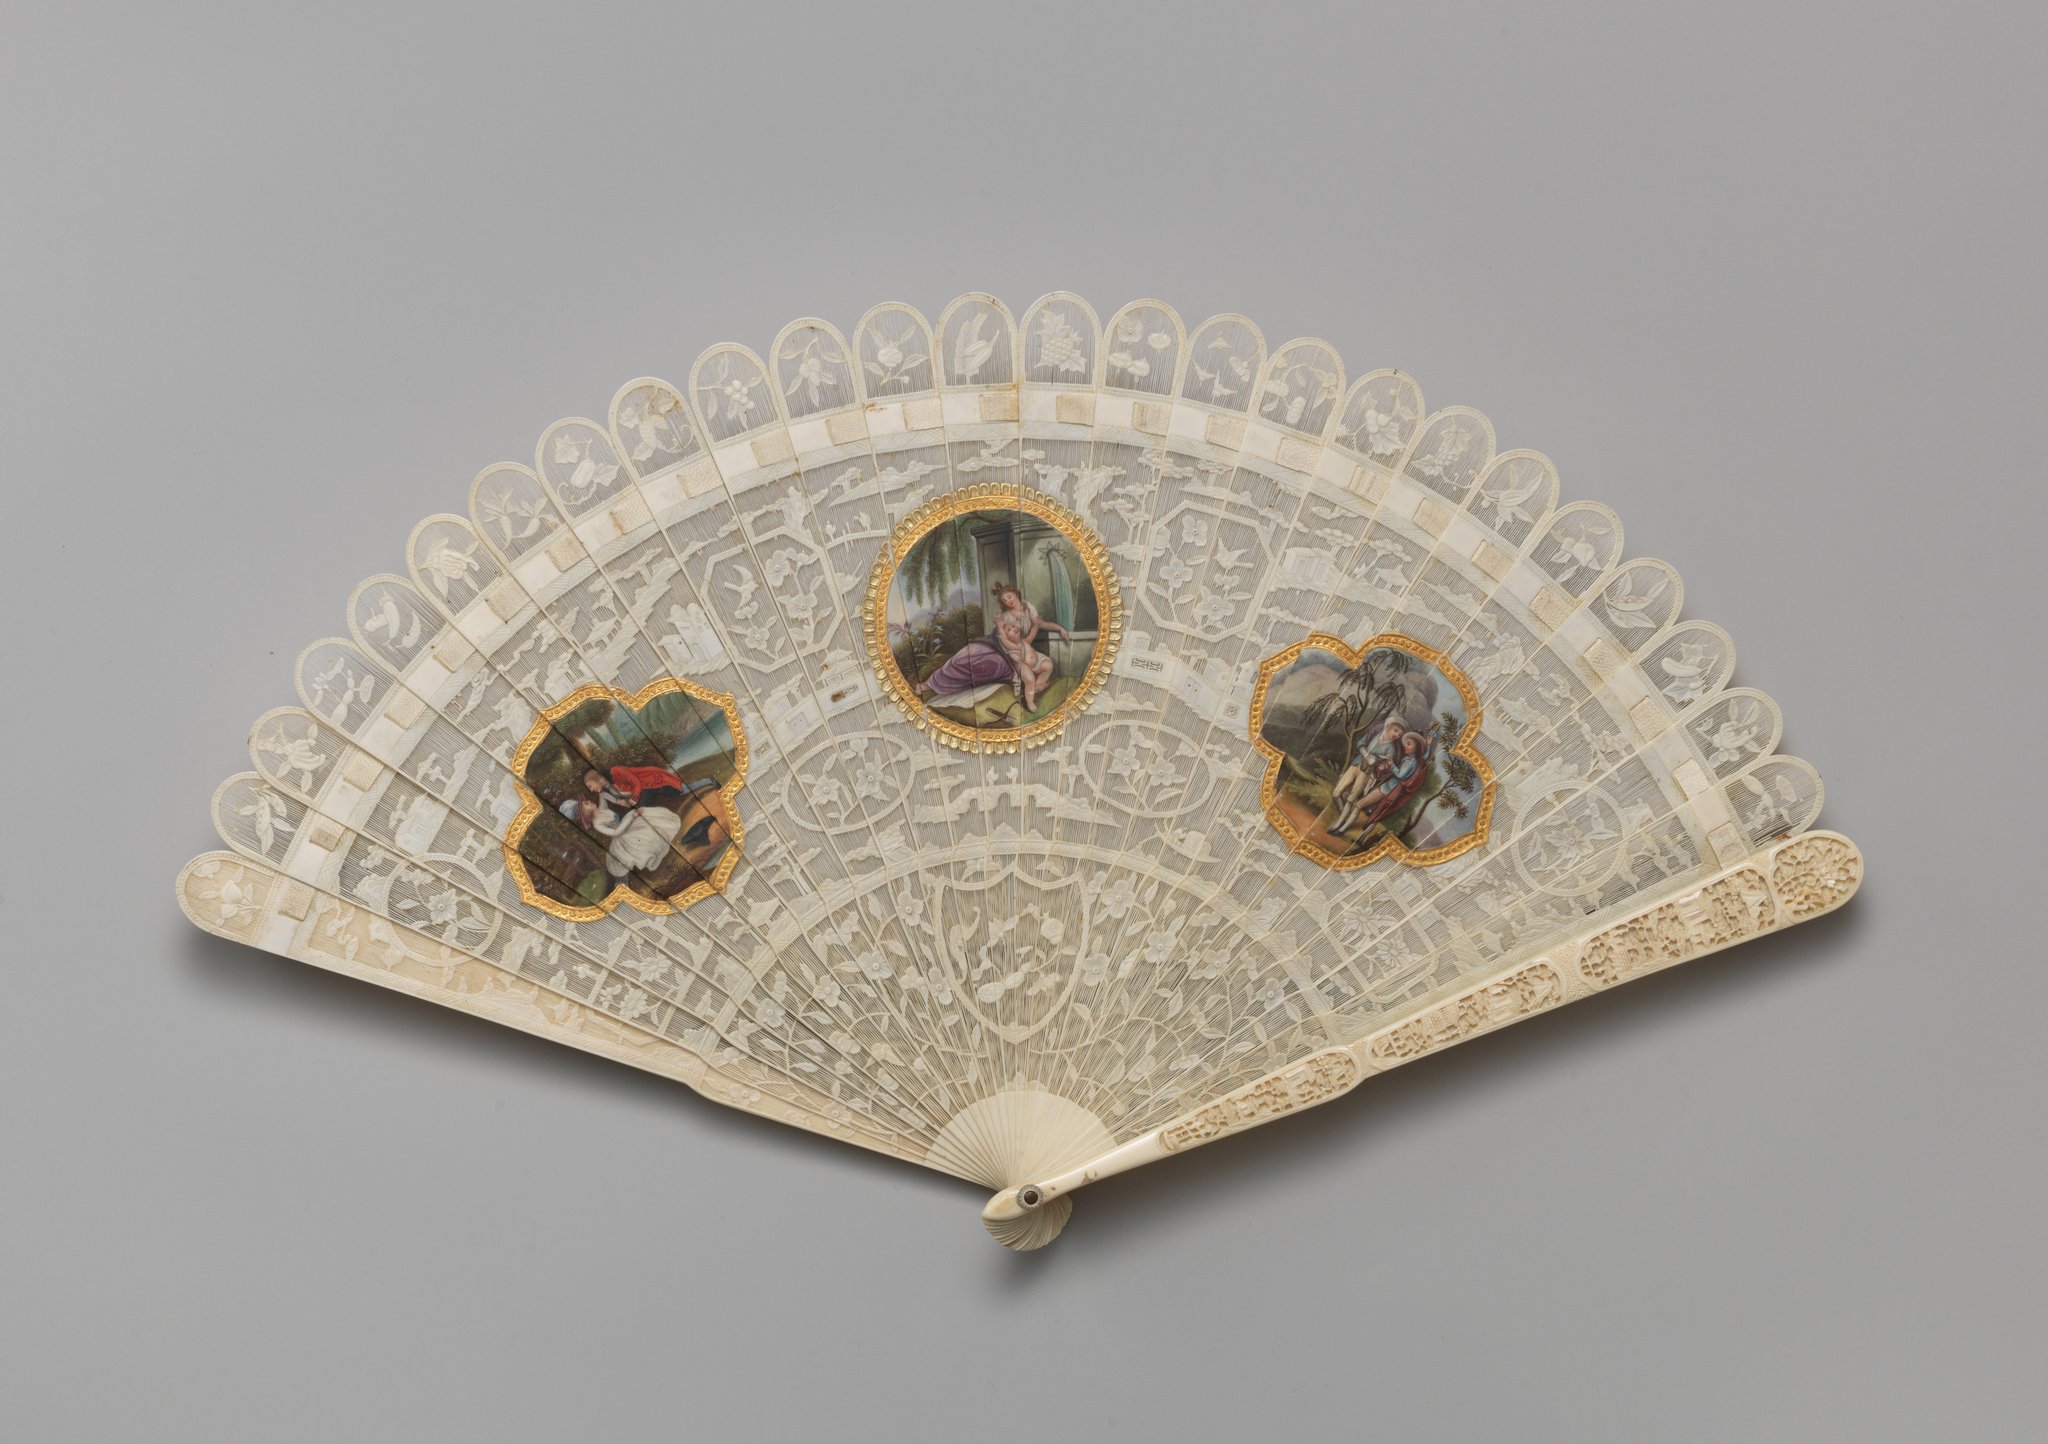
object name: fan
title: Brisé fan, with representations of pastoral scenes flanking Venus and Cupid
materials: ivory, leather, mother of pearl, ribbon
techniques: carving, gilding, painting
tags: men,women